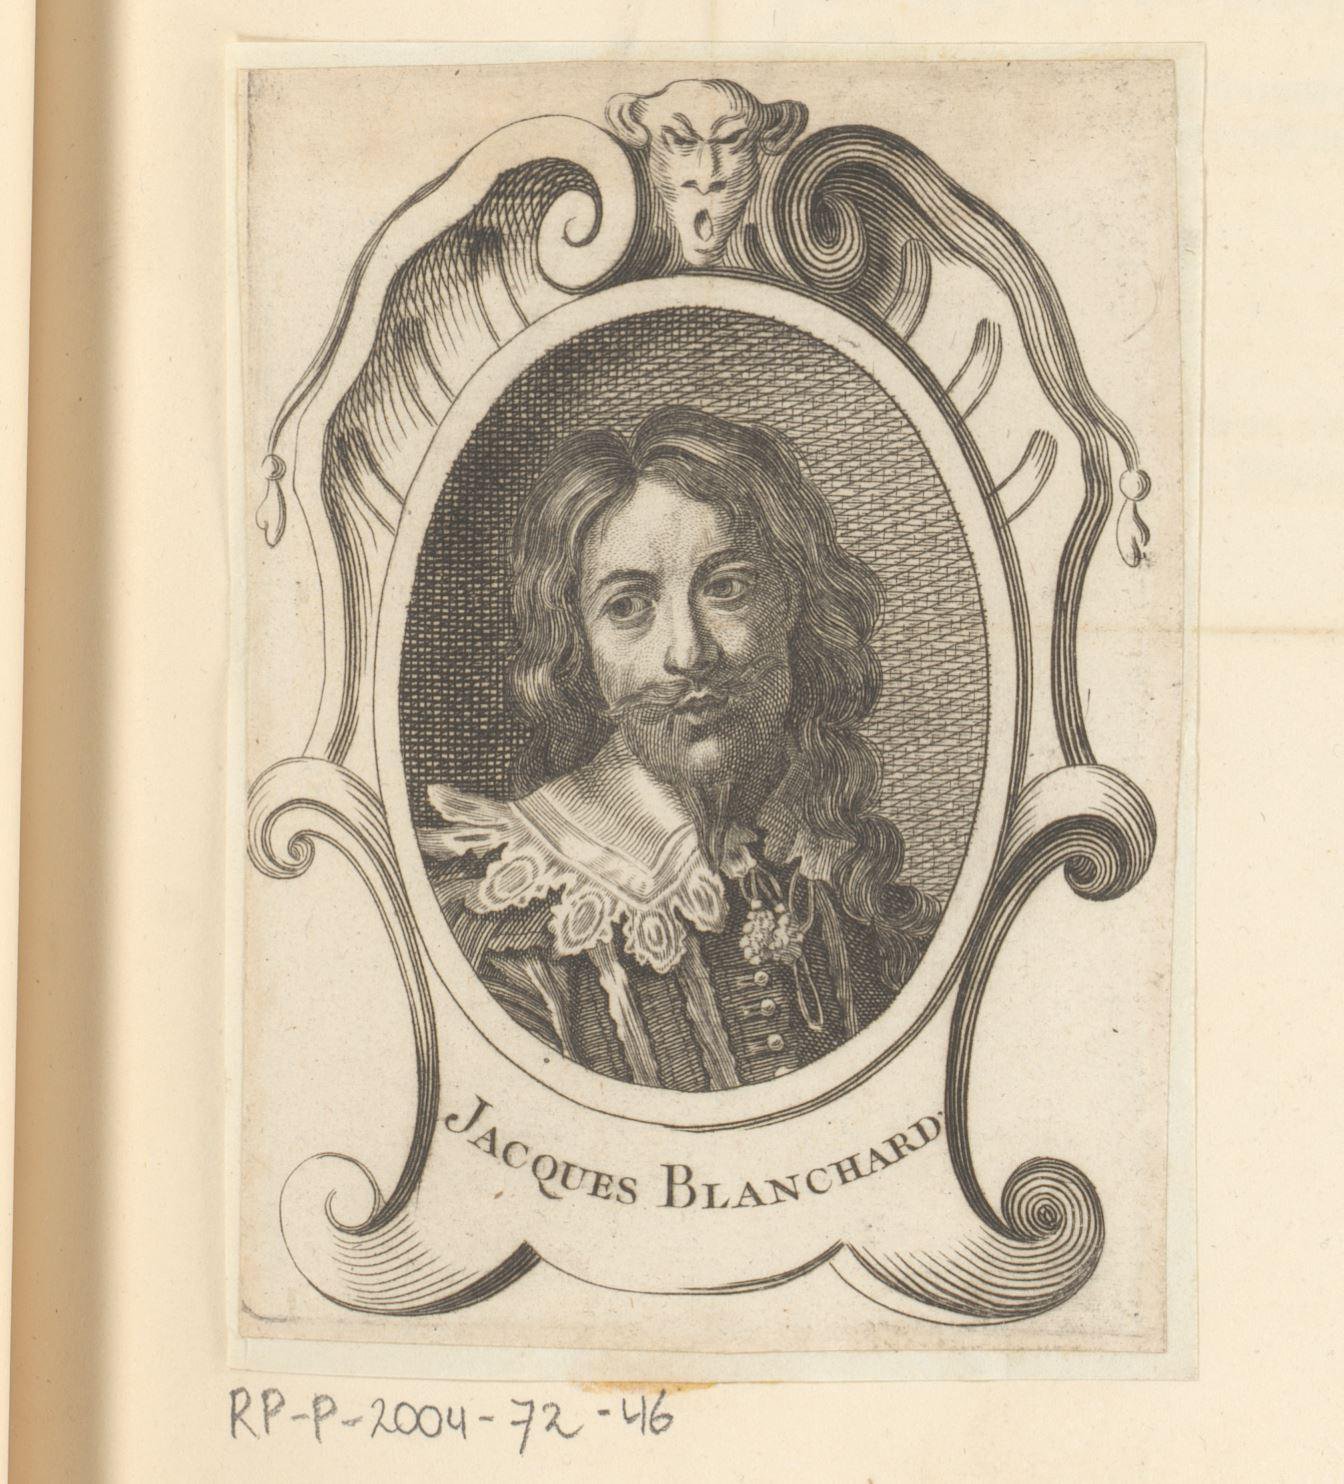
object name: album leaf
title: Portret van Jacques Blanchard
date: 1745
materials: paper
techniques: engraving, letterpress printing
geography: paris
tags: paris, painter, draughtsman, jacques blanchard, historical persons, portrait, self-portrait of painter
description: Prent uit: Dézallier d'Argenville, Antoine Joseph. Abrégé de la vie des plus fameux peintres. 4 dln. Parijs: De Bure l'aîné, 1745, dl. 2, p. 263. De samensteller heeft deze prent in het album geplakt als illustratie bij: Pilkington, Matthew en Johann Heinrich Füssli. A dictionary of painters, from the revival of the art to the present period. 4 dln. Londen: John Crowder, 1805, dl. 1, p. 50.